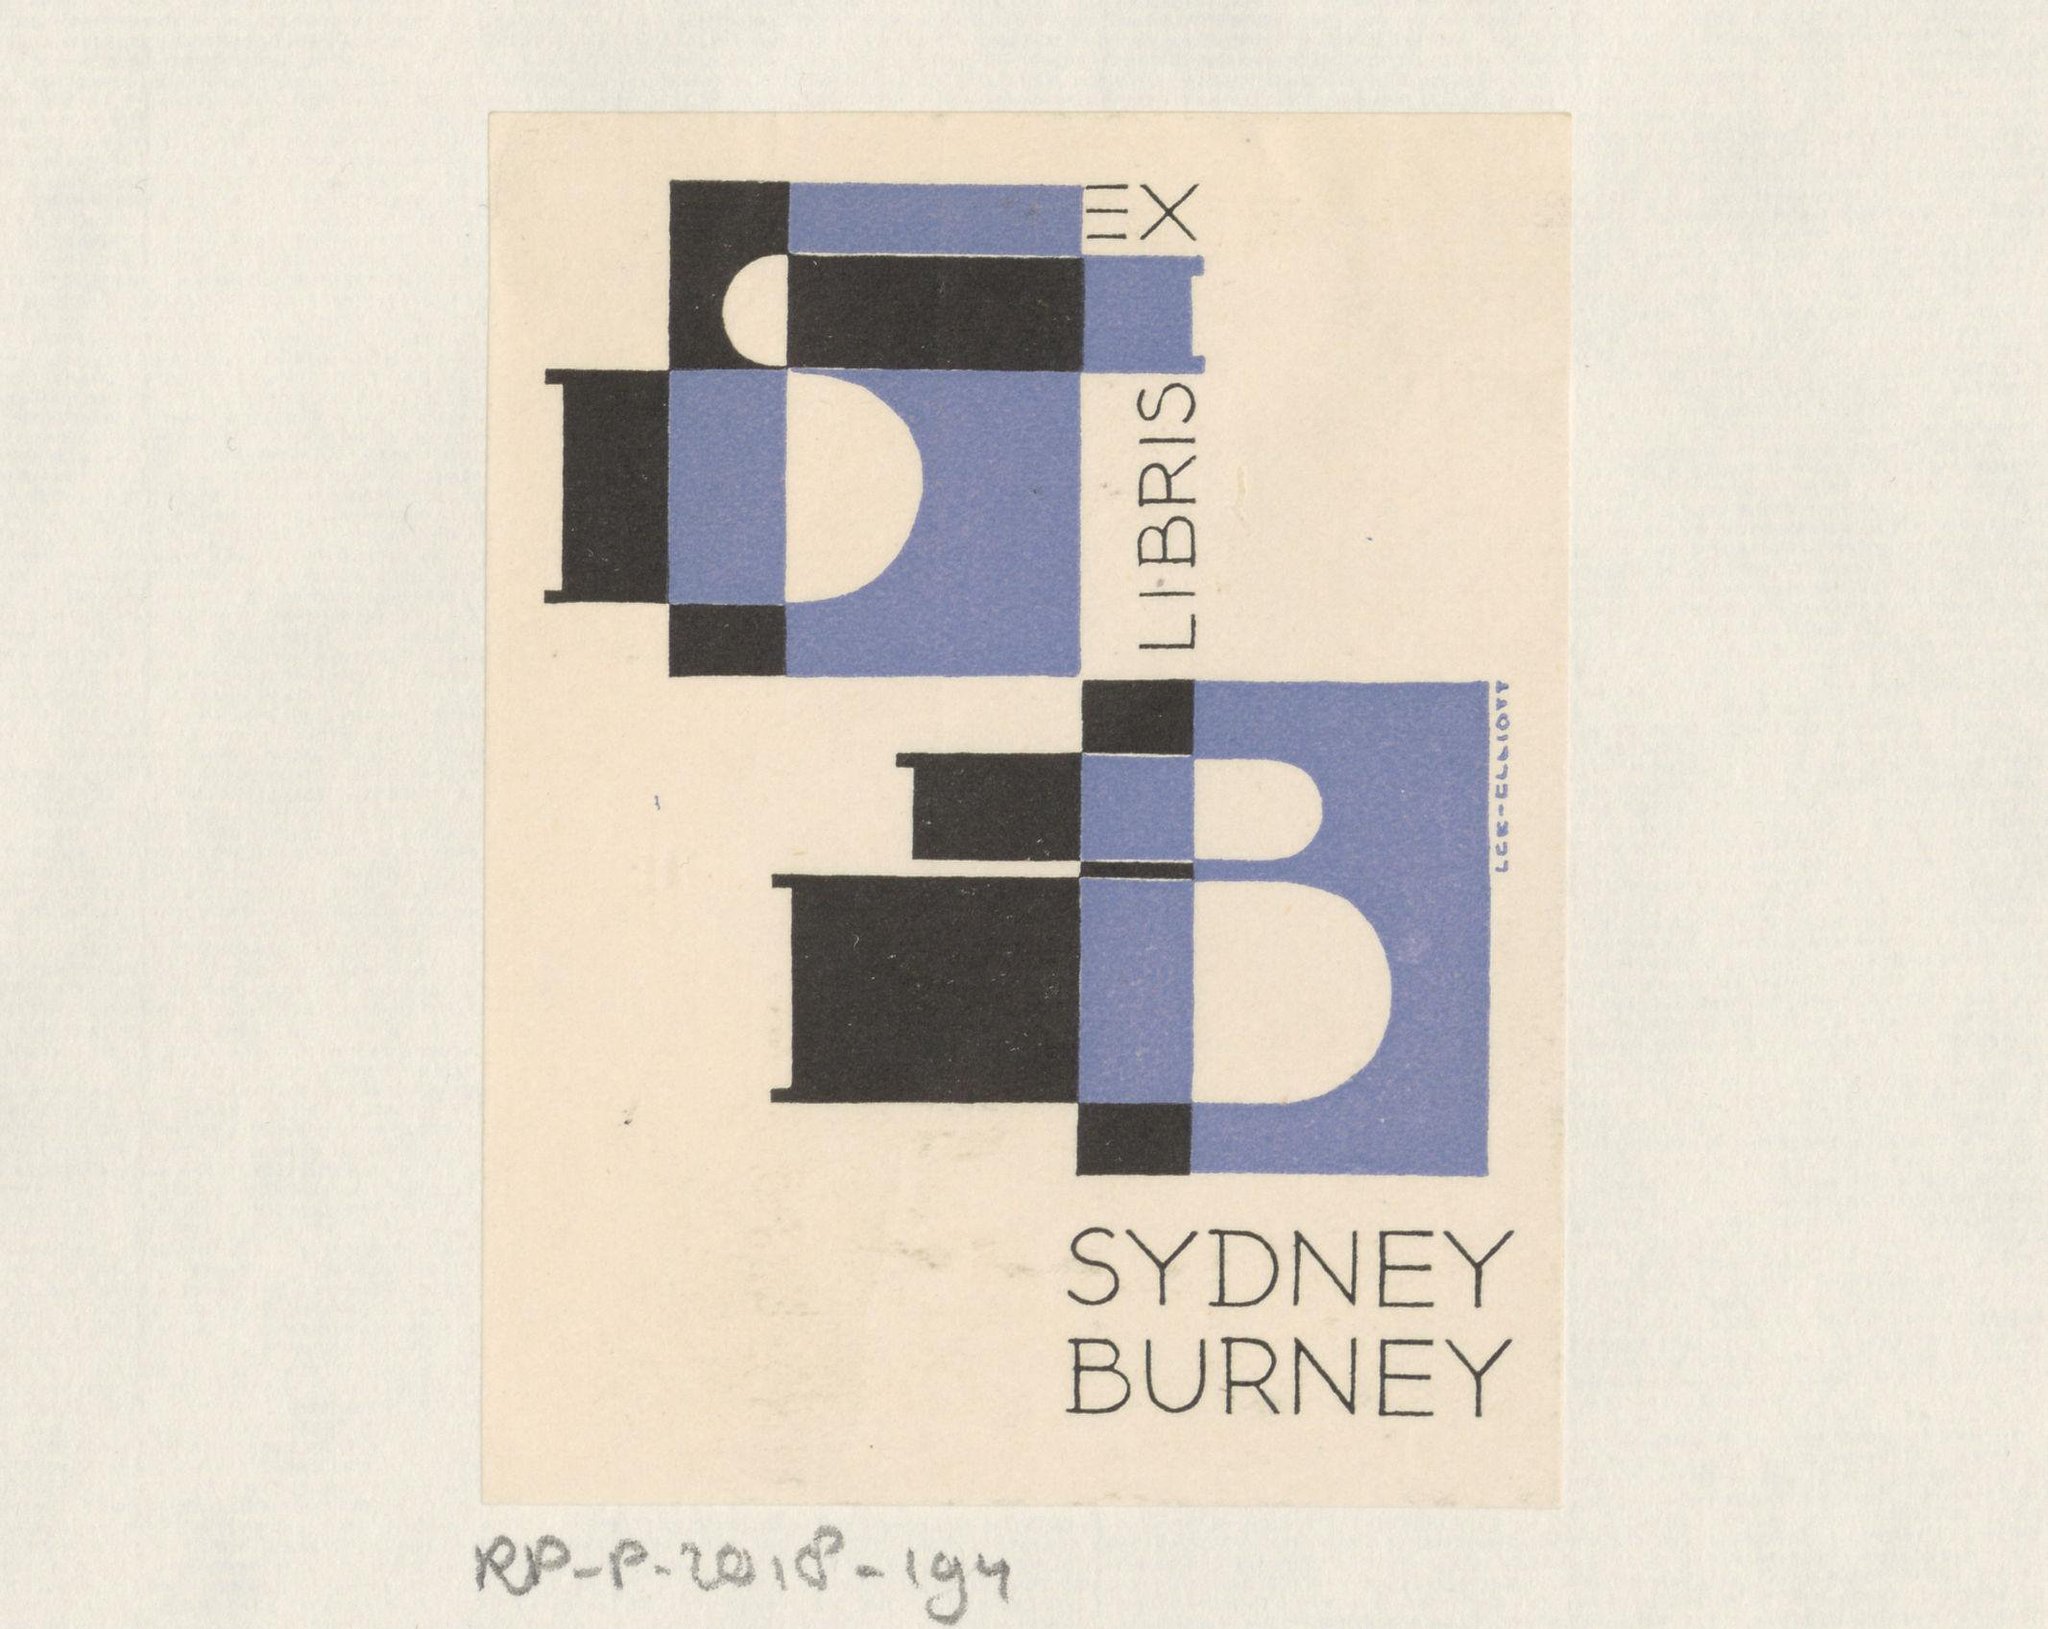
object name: bookplate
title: Ex libris van Sydney Burney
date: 1910-1951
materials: paper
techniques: printing block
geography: england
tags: verzamelaar, kunsthandelaar, syndey burney